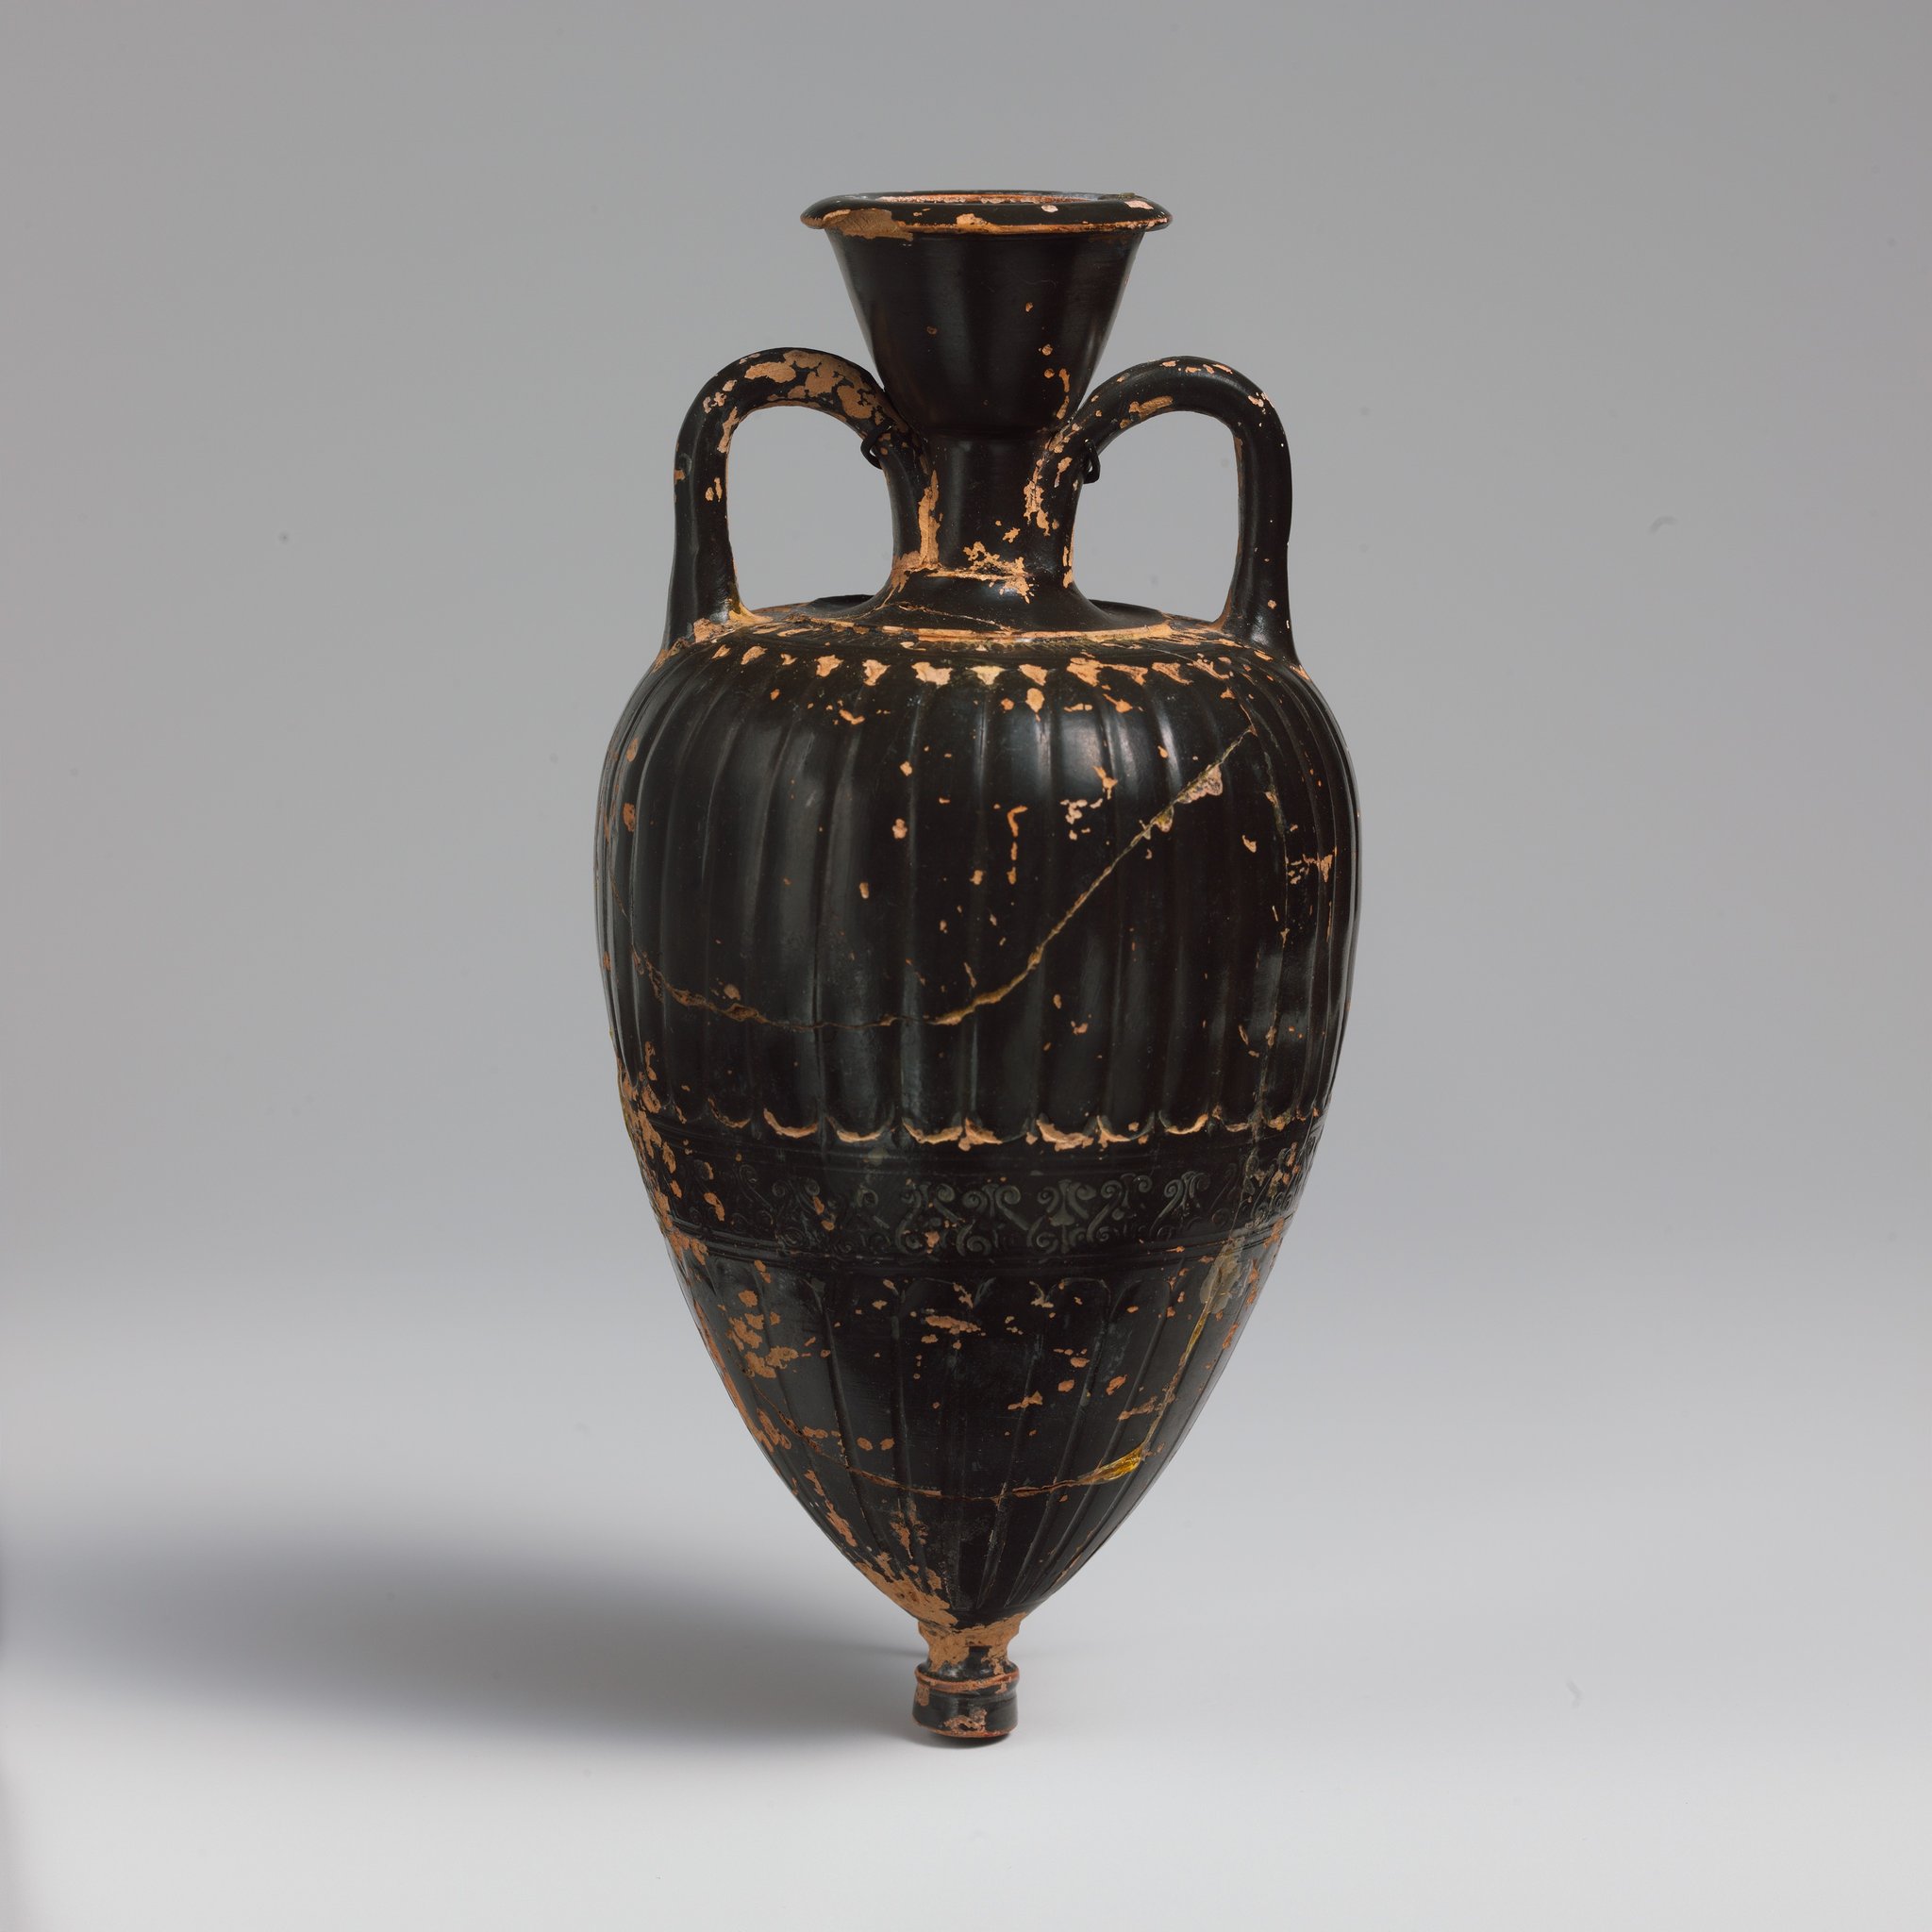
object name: amphoriskos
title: Terracotta amphoriskos (oil flask)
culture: greek, attic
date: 400-301 BCE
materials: terracotta